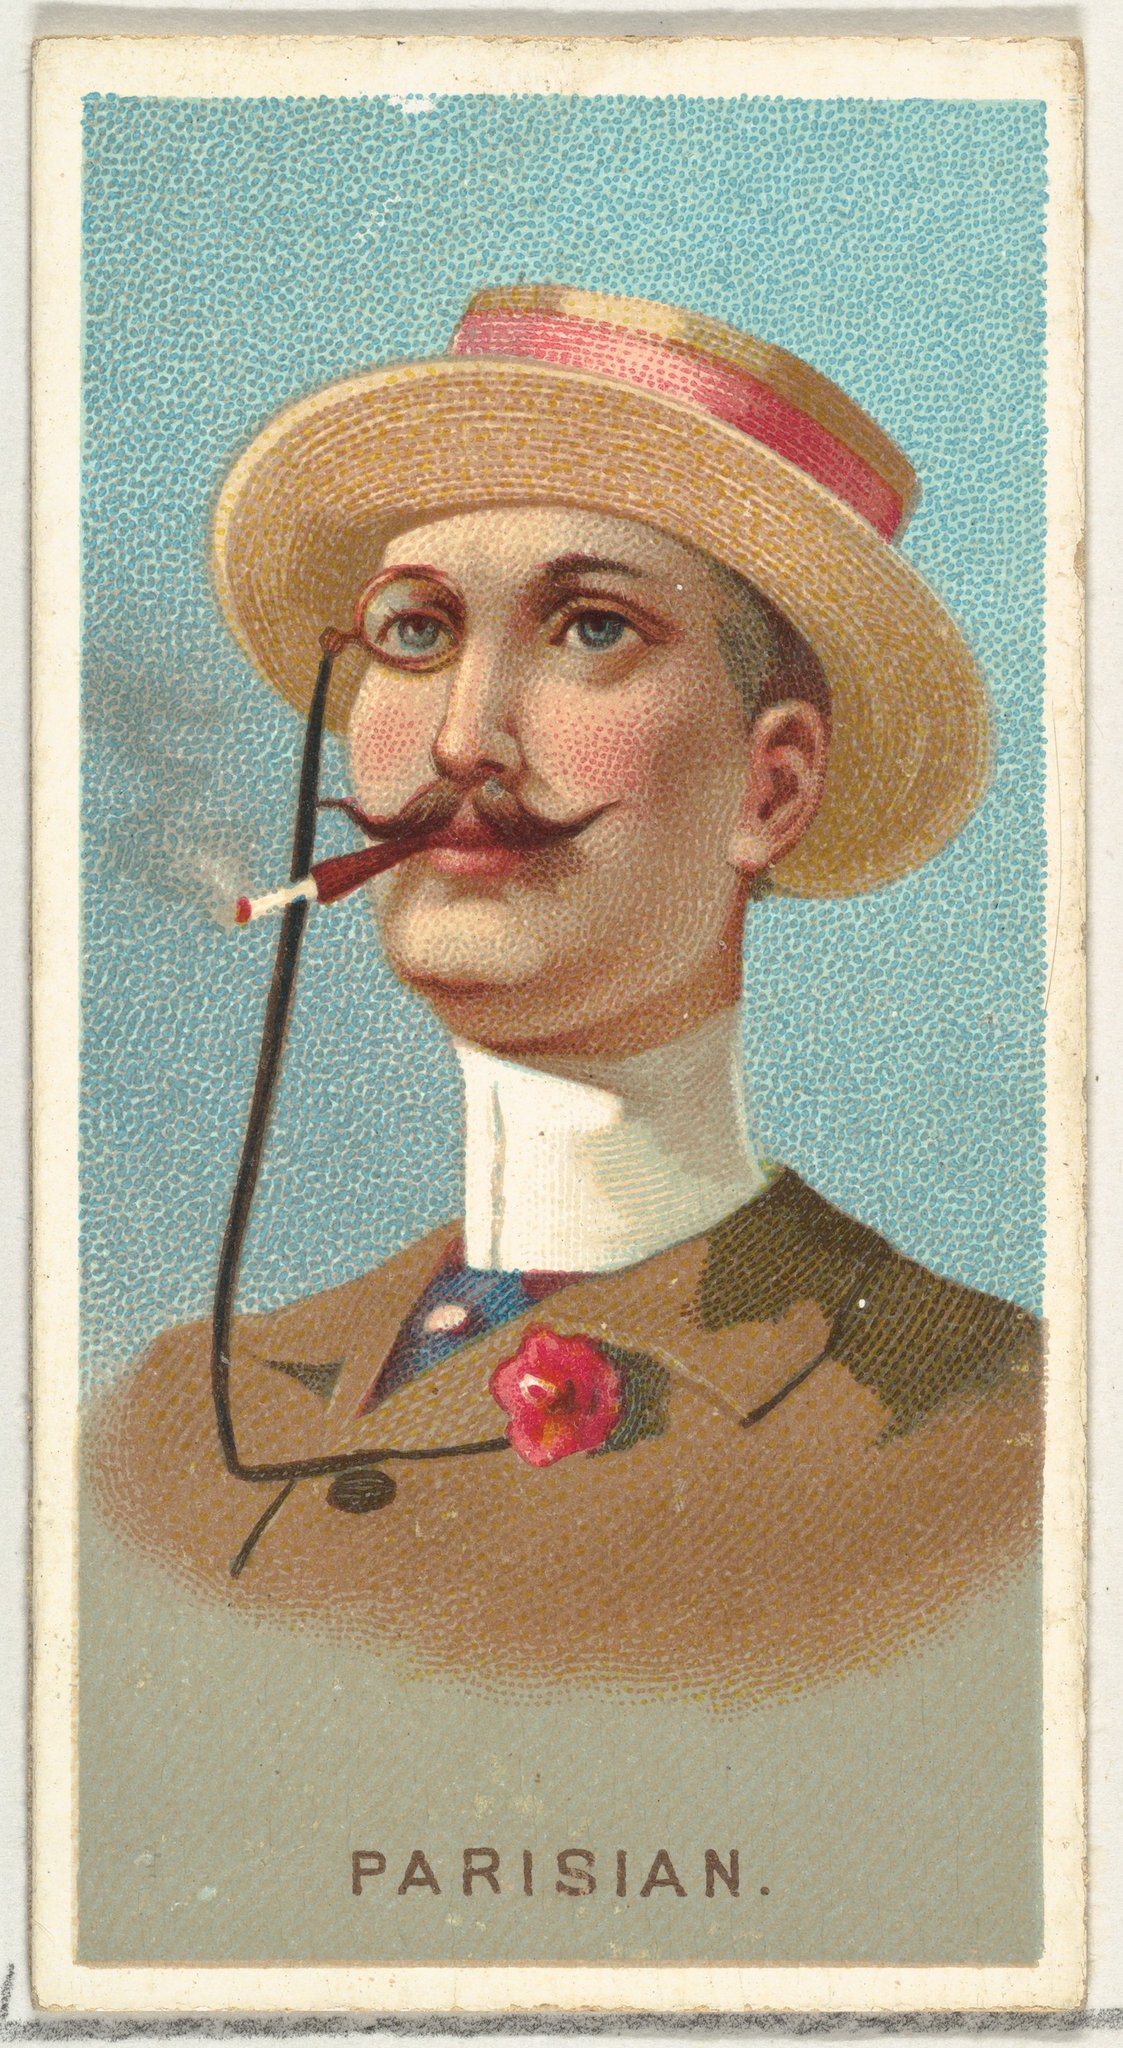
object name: print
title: Parisian, from World's Smokers series (N33) for Allen & Ginter Cigarettes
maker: allen & ginter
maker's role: publisher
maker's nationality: american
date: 1888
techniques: color lithograph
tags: men,smoking